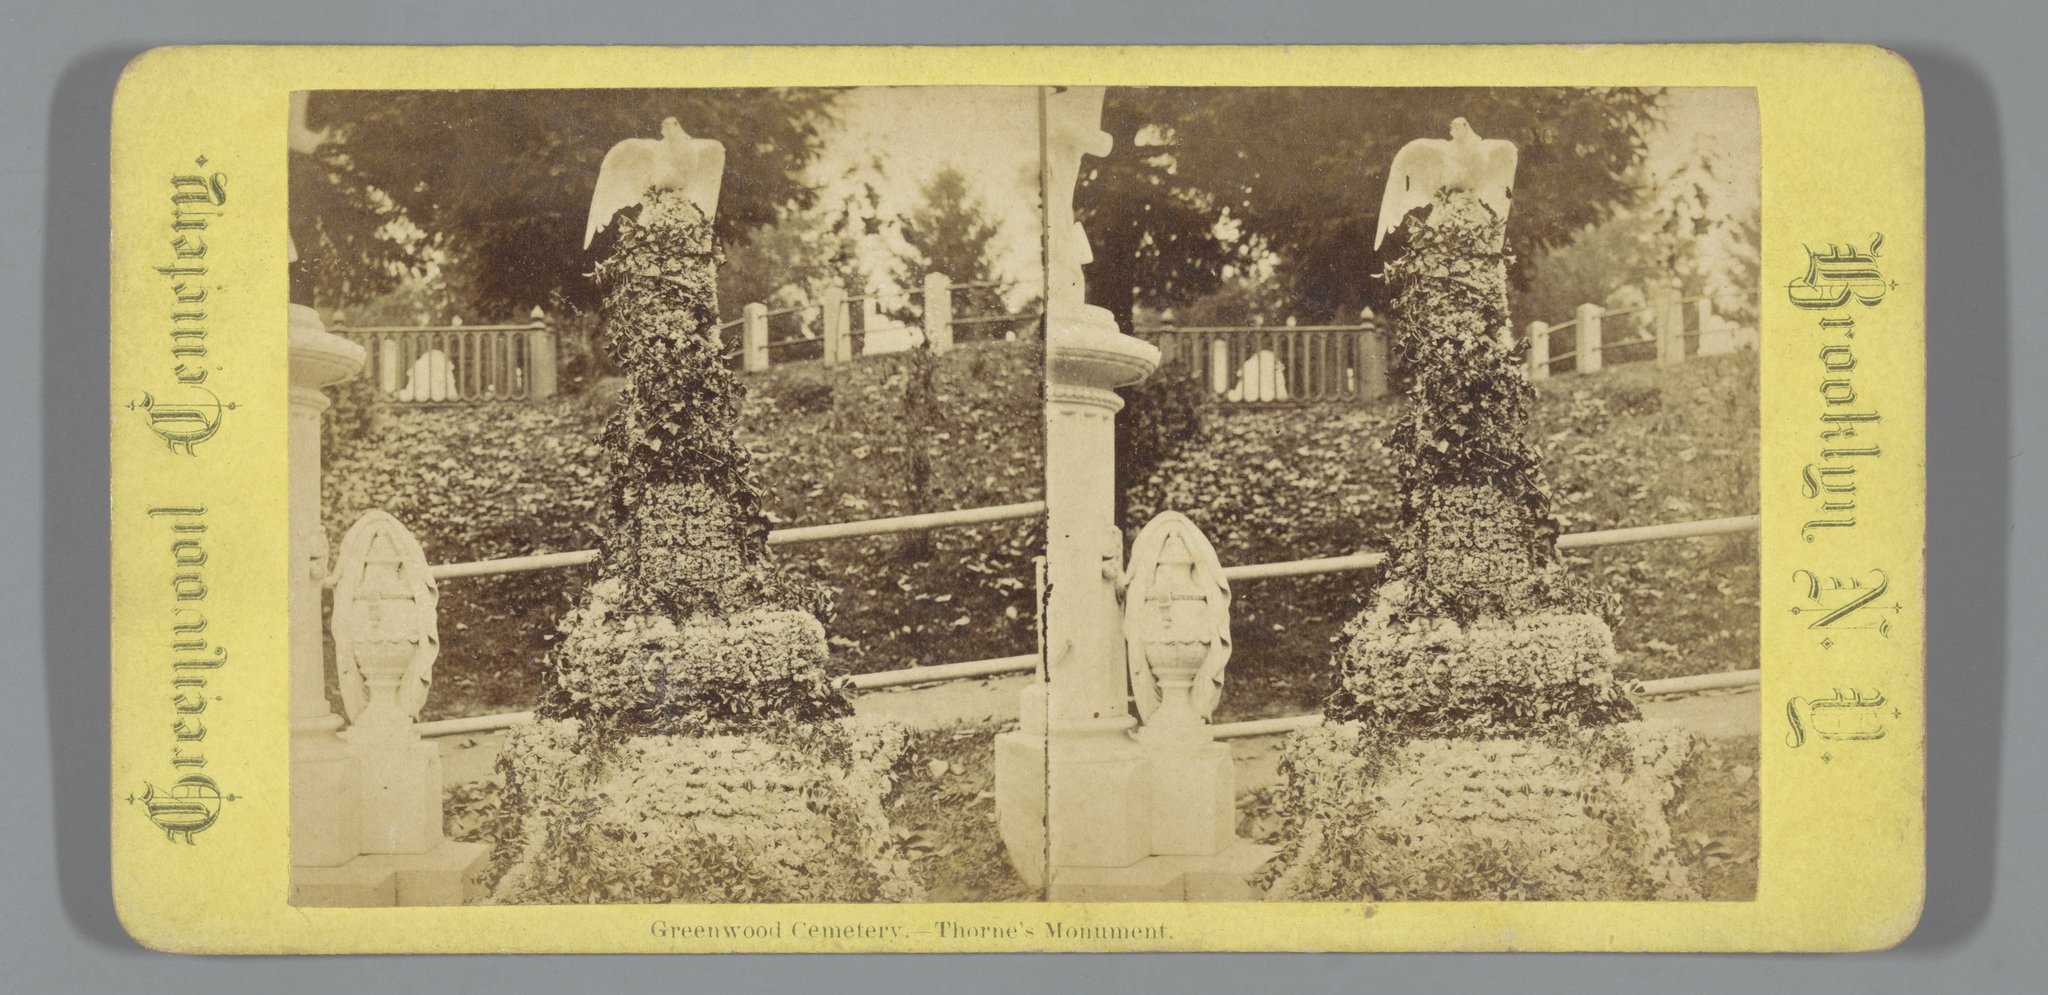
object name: stereograph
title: Thorne Monument op Greenwood Cemetery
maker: Anonymous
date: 1868-1890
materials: cardboard, paper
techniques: albumen print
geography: new york city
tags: cemetery, park-like burying ground, new york (city)